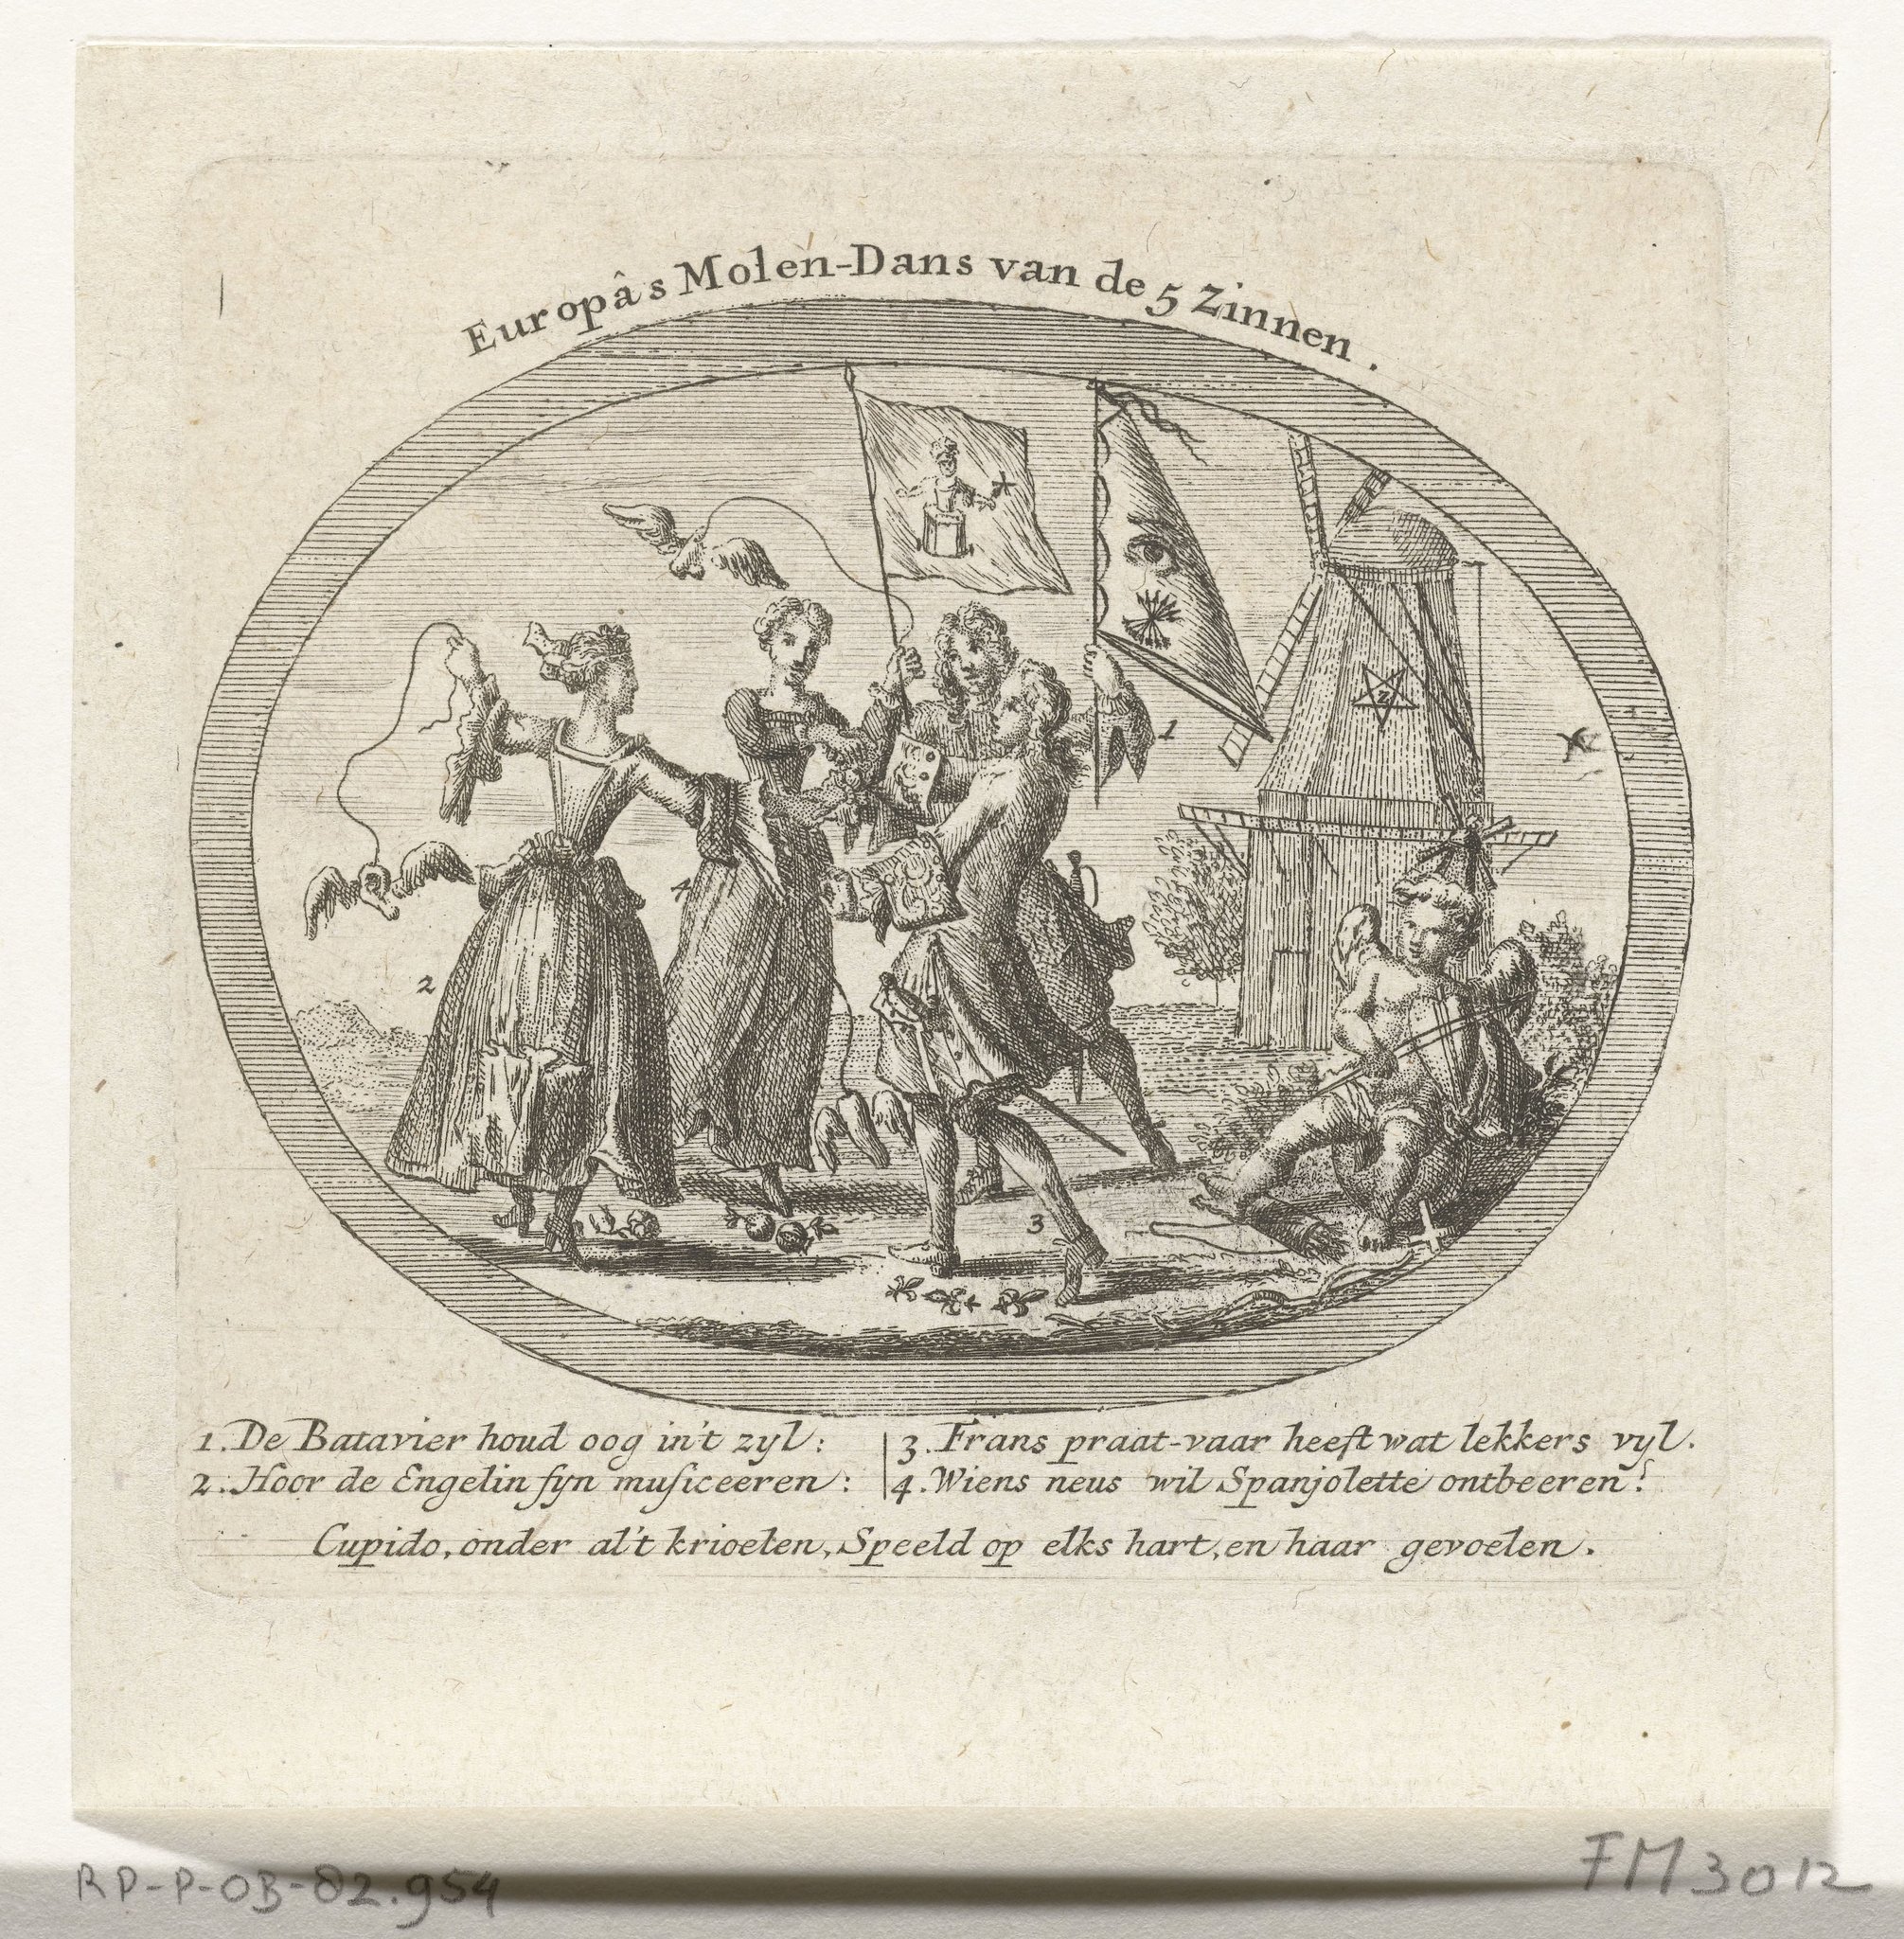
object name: print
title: Europa's molendans, ca. 1700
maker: Anonymous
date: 1690-1710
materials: paper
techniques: etching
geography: northern netherlands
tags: more than one couple dancing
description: Europa's molendans. Politieke allegorie waarin op de muziek van Cupido met elkaar dansen: Nederland, Frankrijk, Engeland en Spanje. Op de achtergrond een molen, op de grond Engelse rozen en Franse lelies. Mogelijk in verband met de Spaanse Successieoorlog.